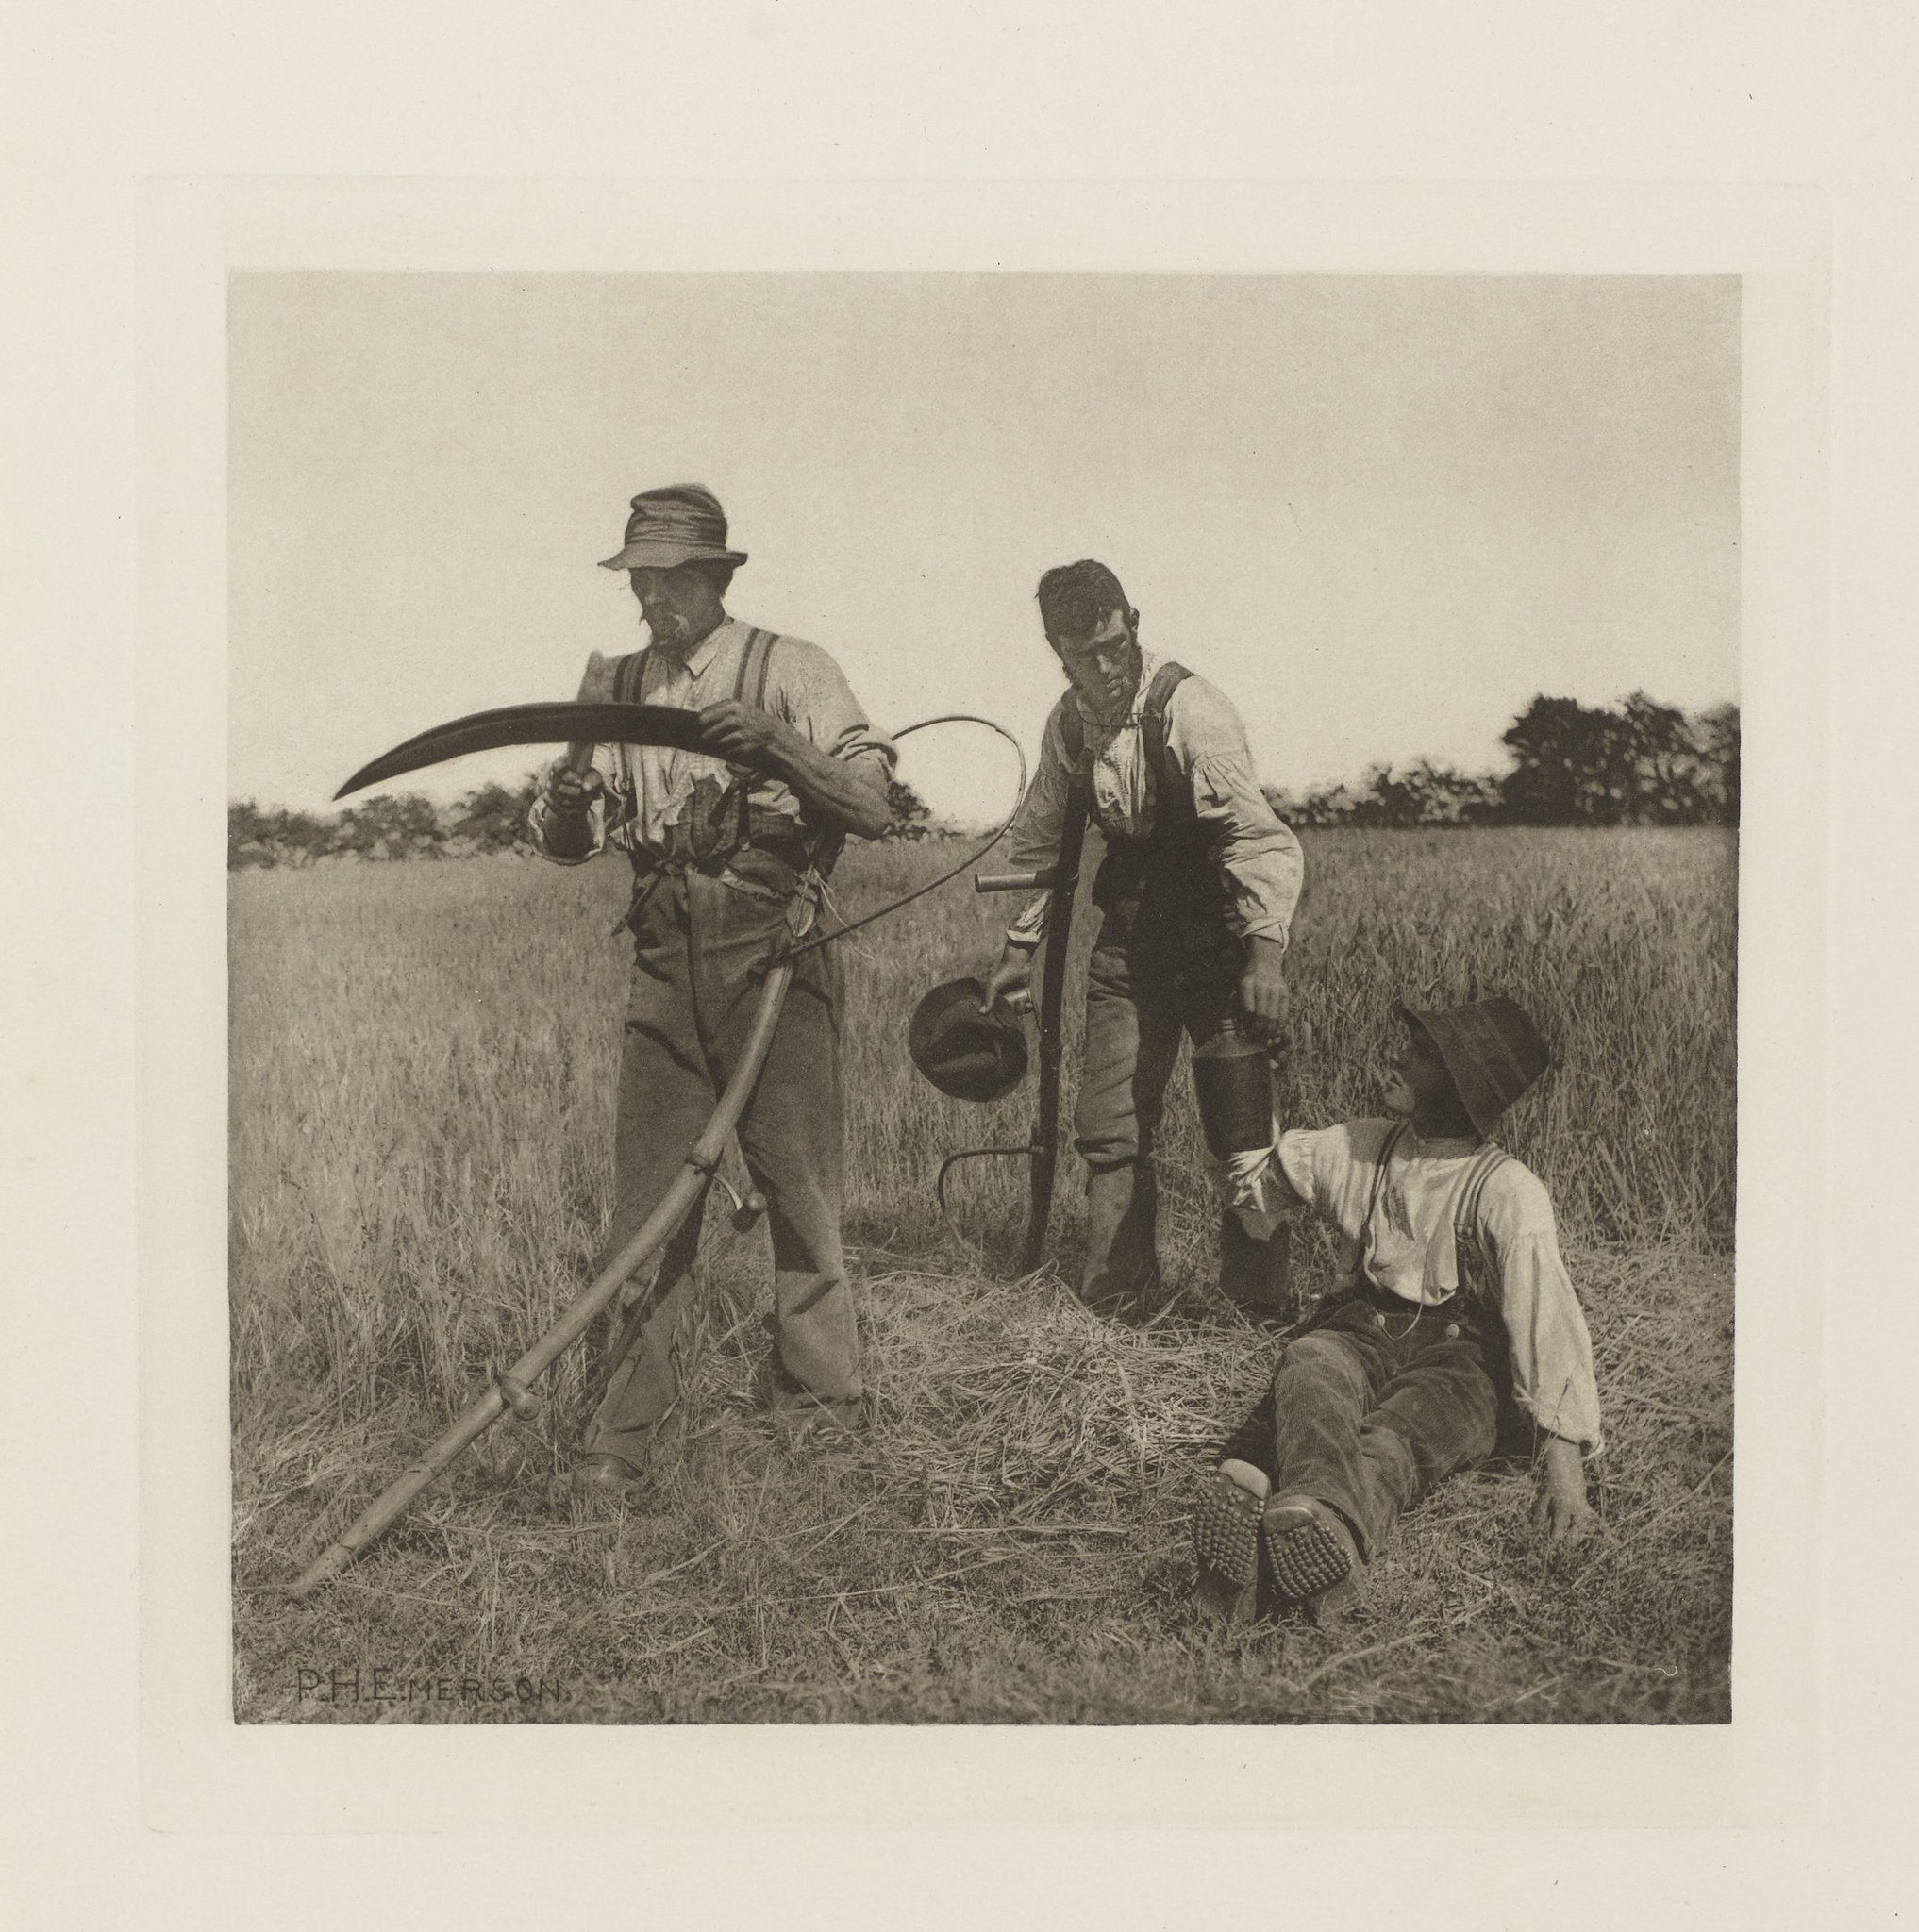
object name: photomechanical print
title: Farmworkers during the Barley Harvest in Suffolk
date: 1883-1888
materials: cardboard, paper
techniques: photoaquatint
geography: suffolk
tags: harvest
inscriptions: inscription: ‘Plate VII.’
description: Unlike most of Emerson’s photographs, this one from Pictures of East Anglian Life seems rather posed. Perhaps he was thinking of the paintings by the famous French Realists Gustave Courbet and Jules Breton. He wrote the following about this in his book: ‘I have endeavoured in the plates to express sympathetically various phases of peasant and fisherfolk life...’